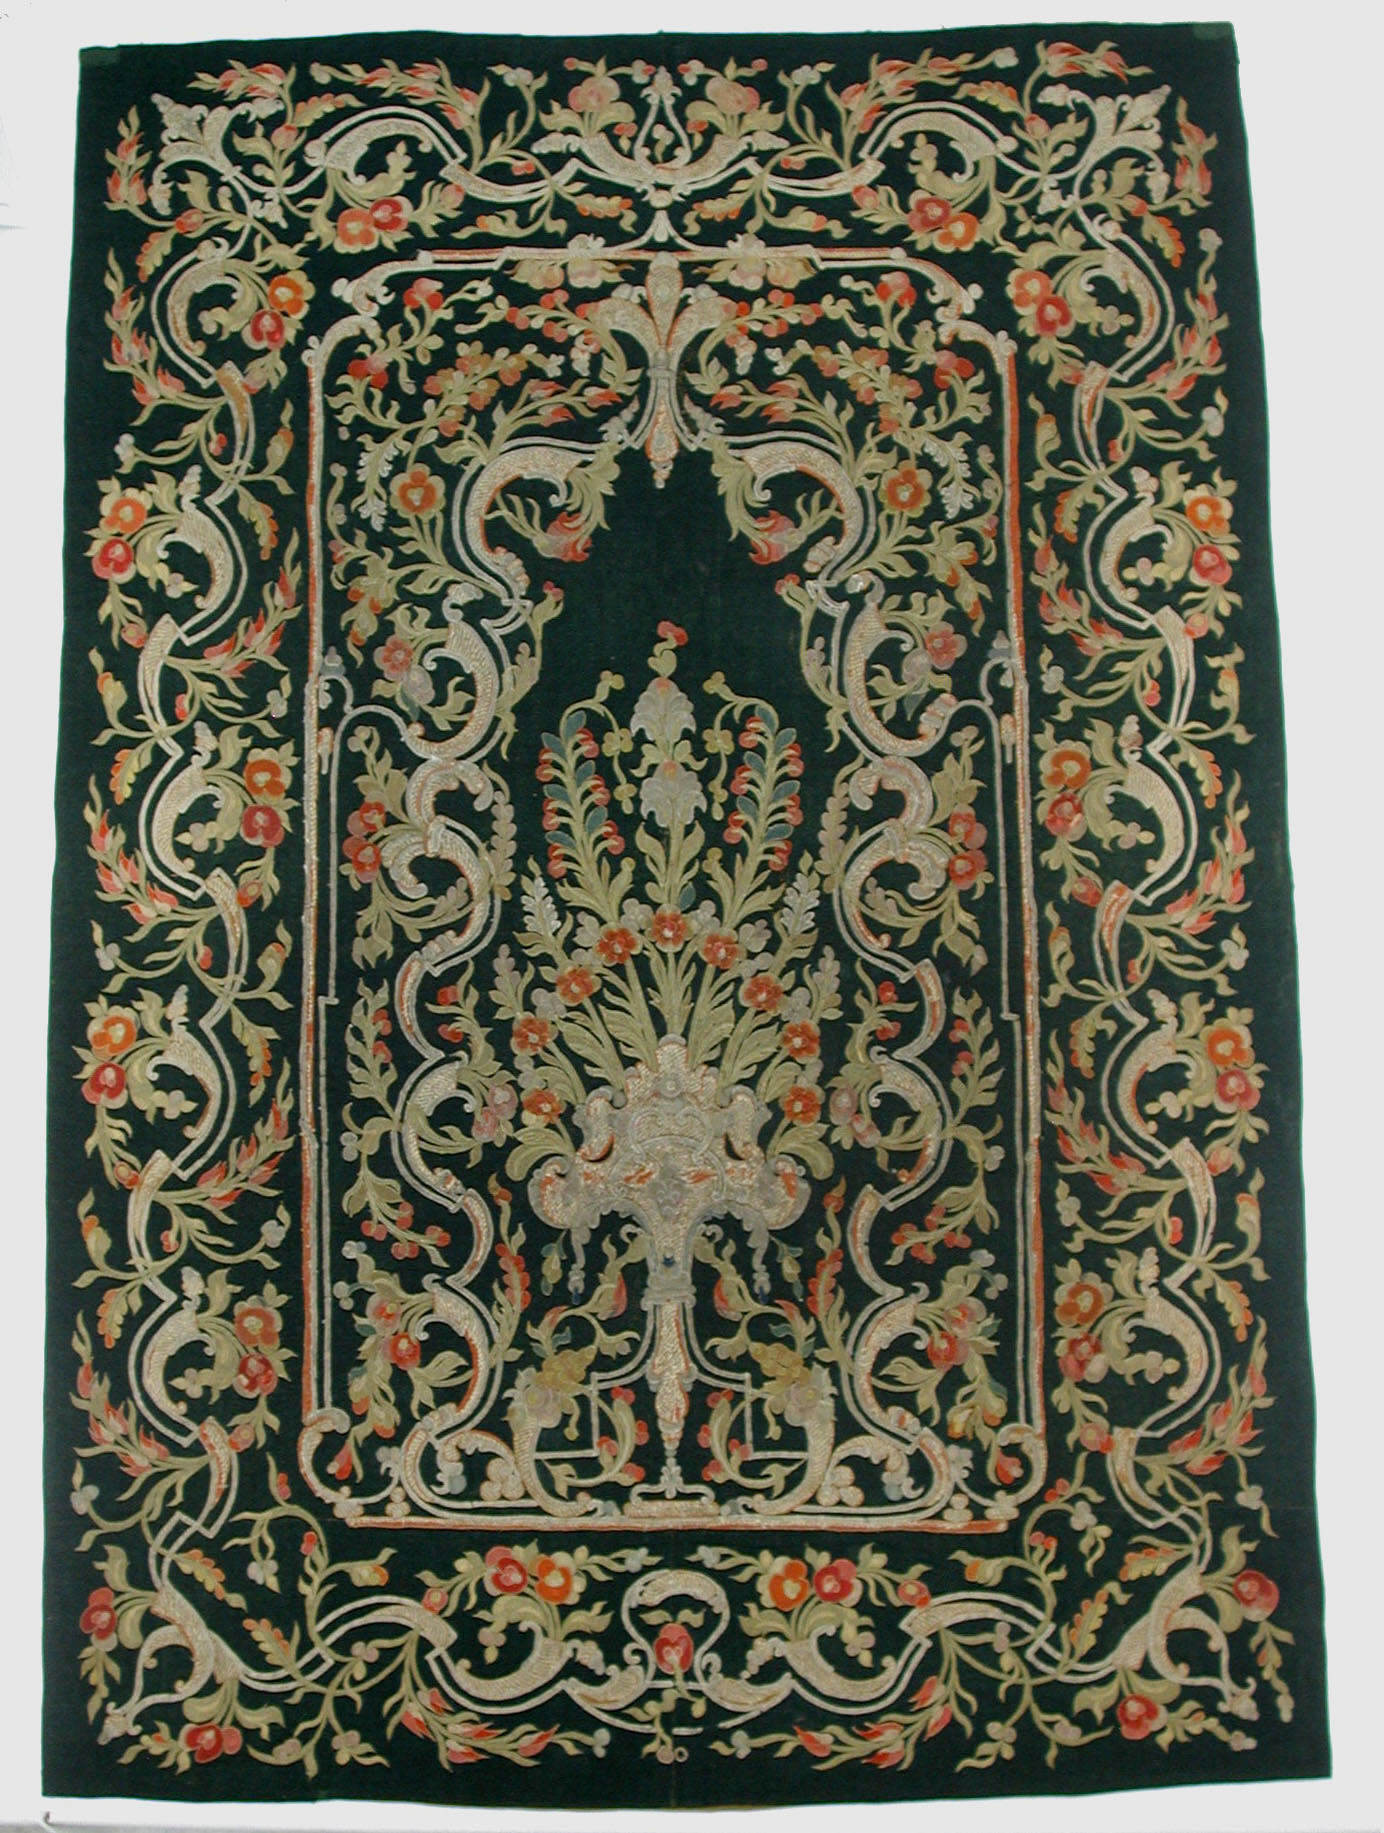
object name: hanging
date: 1701-1800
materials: textile, silk, thread, wool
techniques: lining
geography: iran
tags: flowers